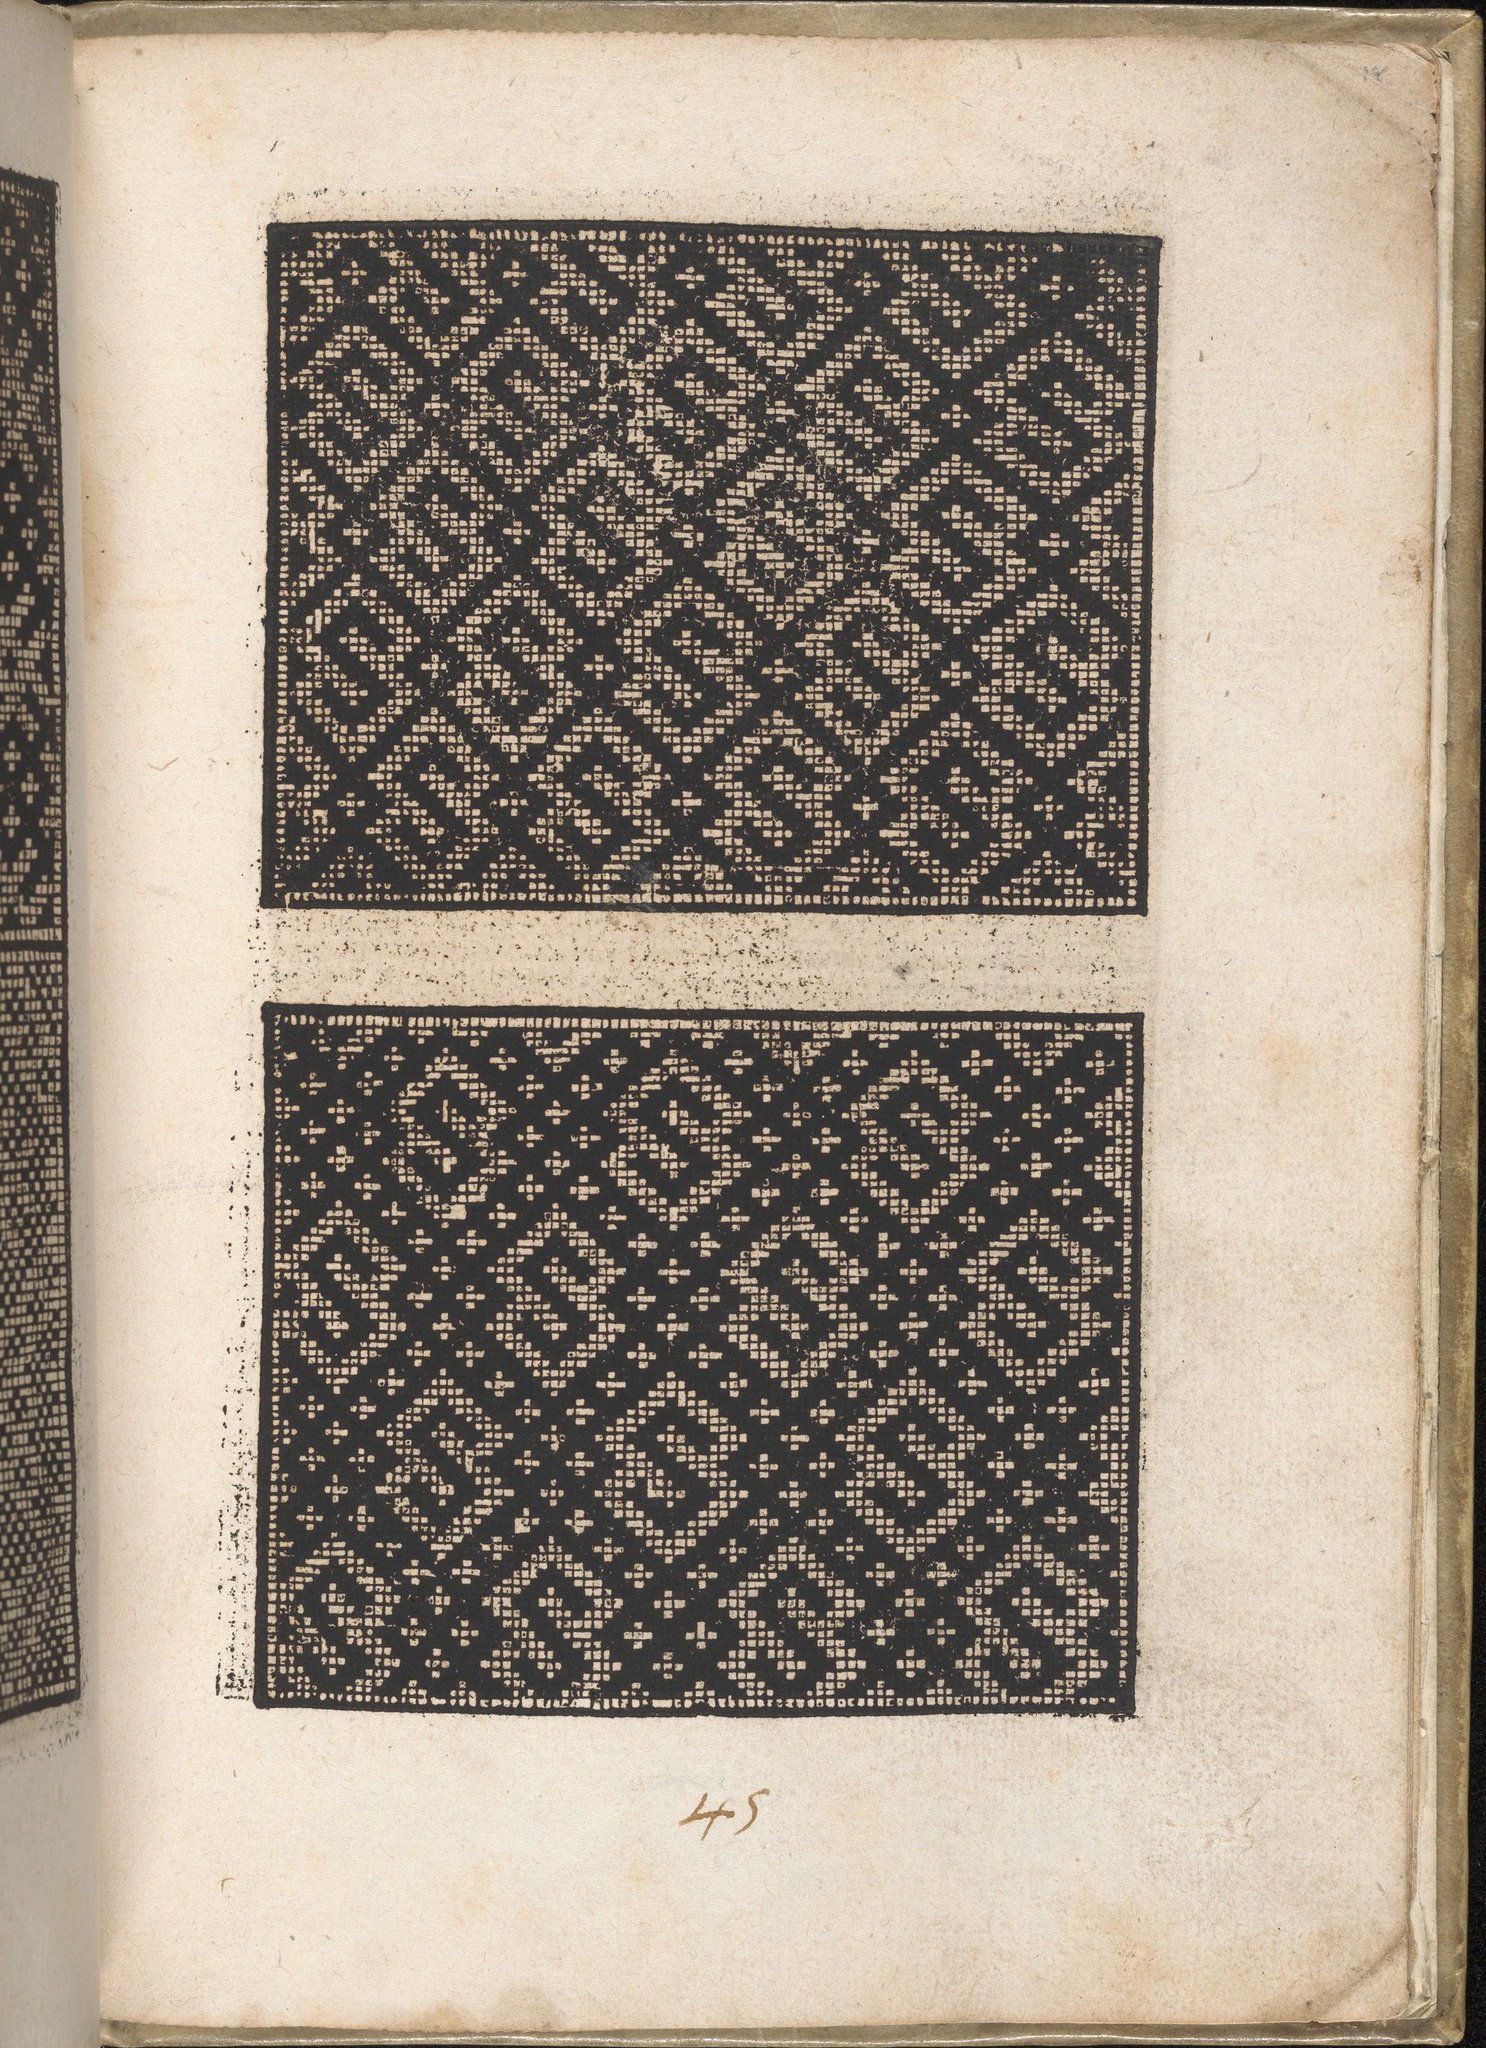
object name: book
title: Page 19r, from "Eyn New Kunstlichboich"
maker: peter quentel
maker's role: publisher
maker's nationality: german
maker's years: 1500-1550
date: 1529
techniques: woodcut